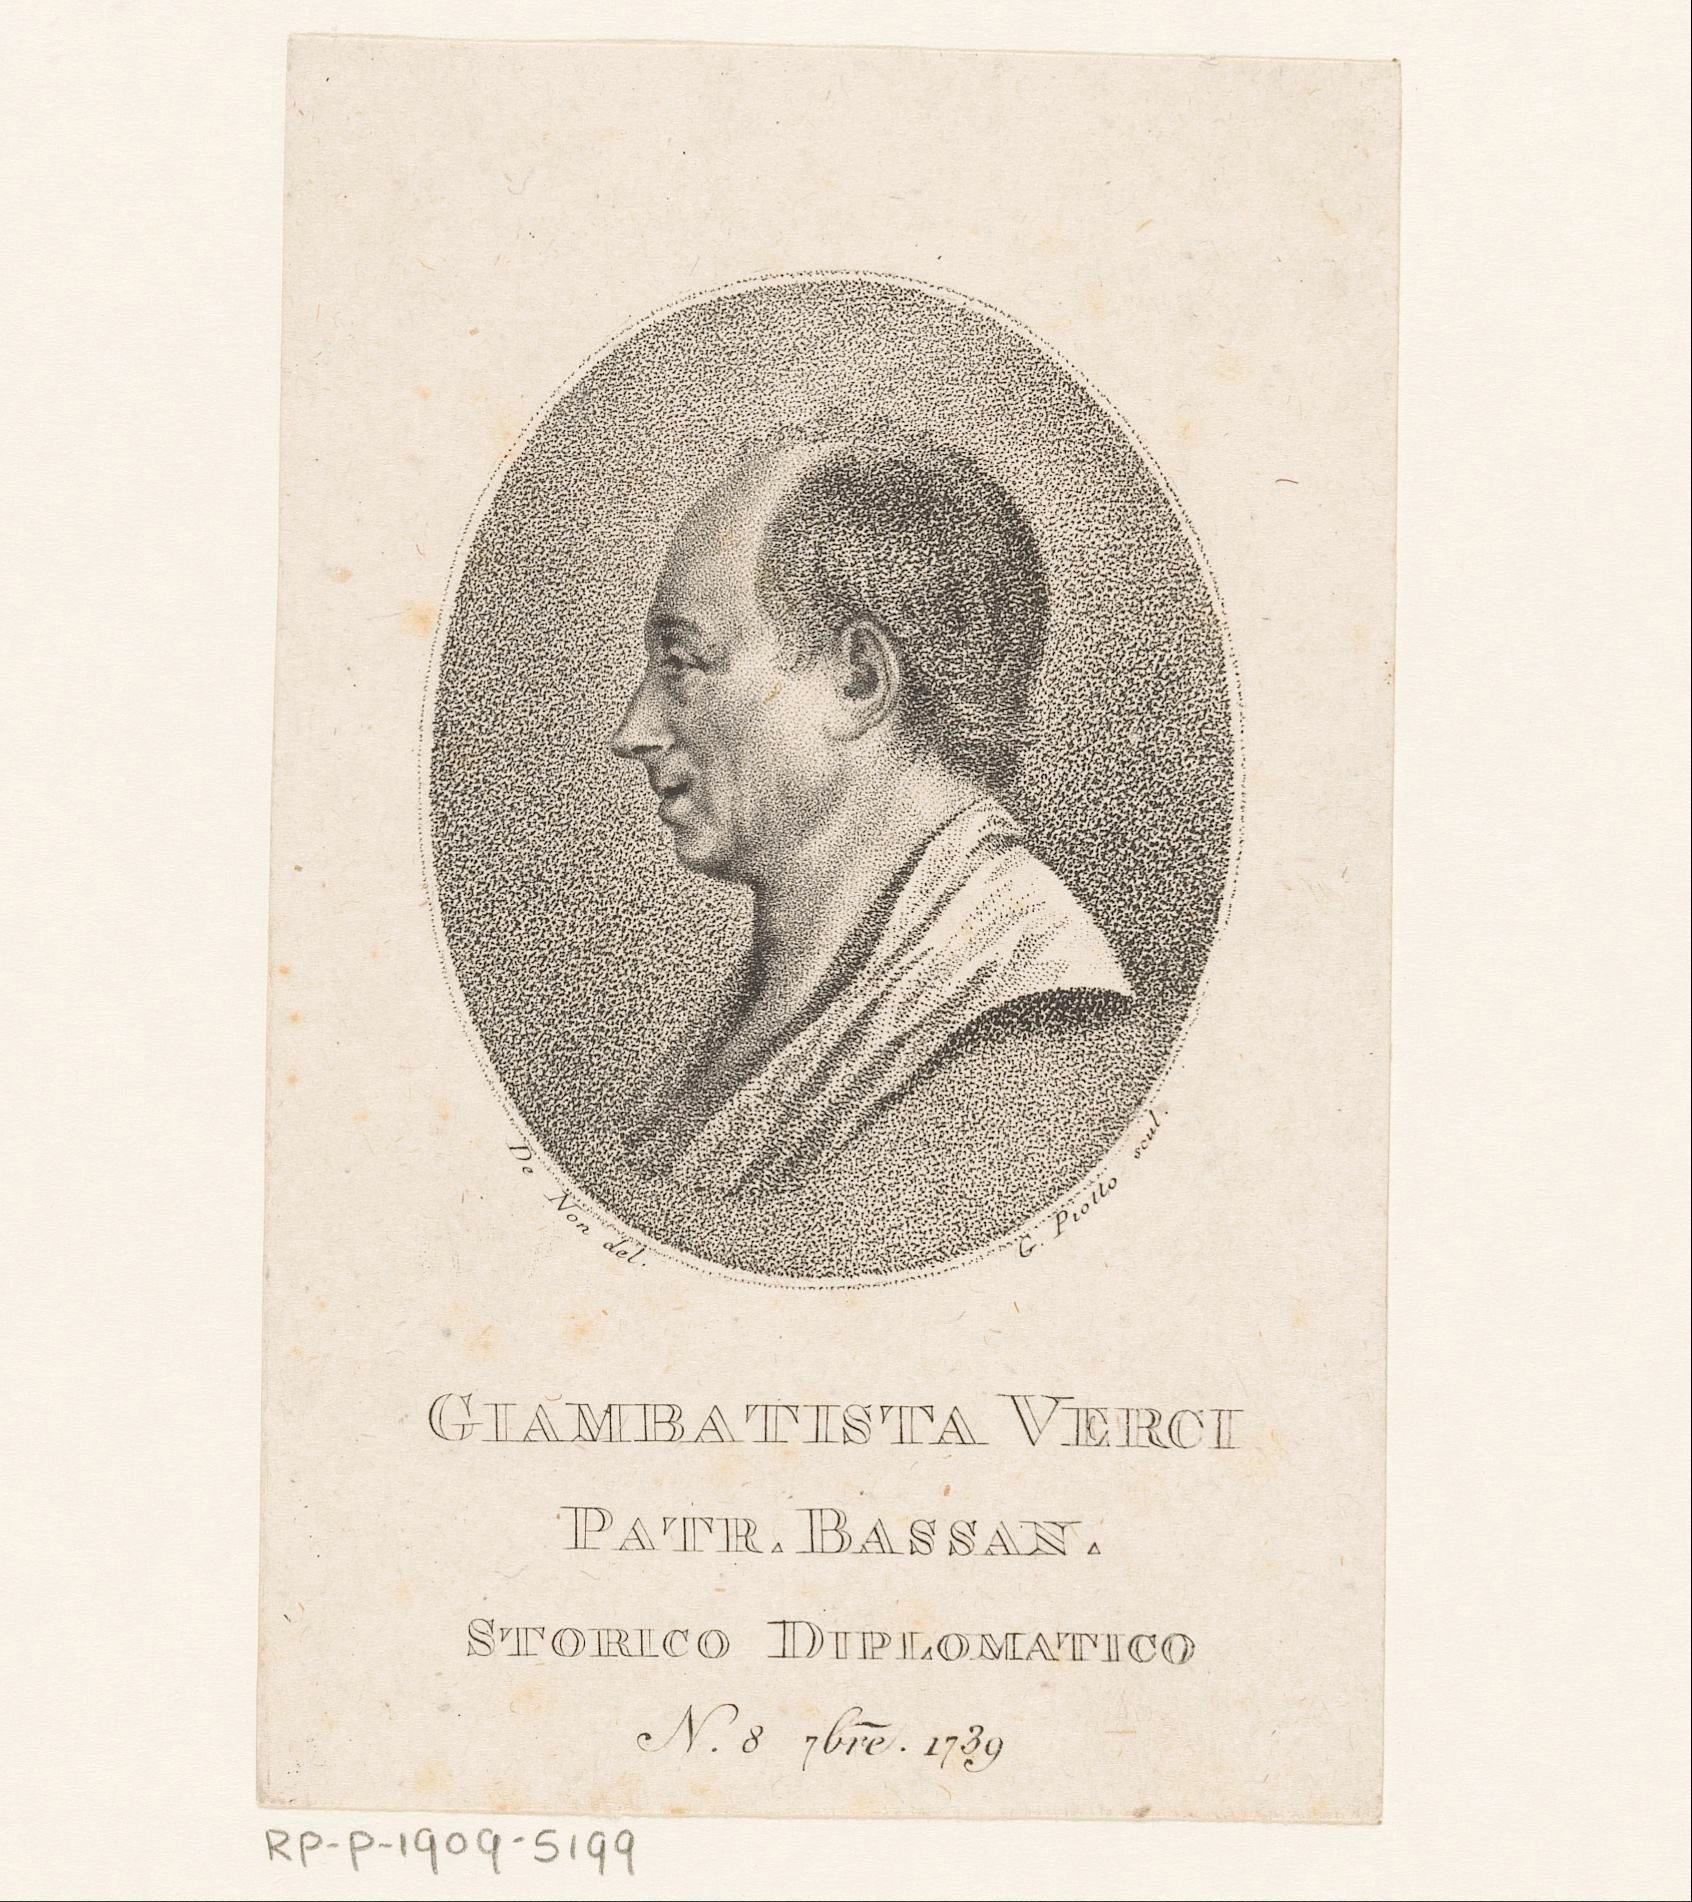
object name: print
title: Portret van schrijver en historicus Giambattista Verci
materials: paper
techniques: engraving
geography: italy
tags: historical persons, portrait of a writer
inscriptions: collector's mark: Lugt 2228